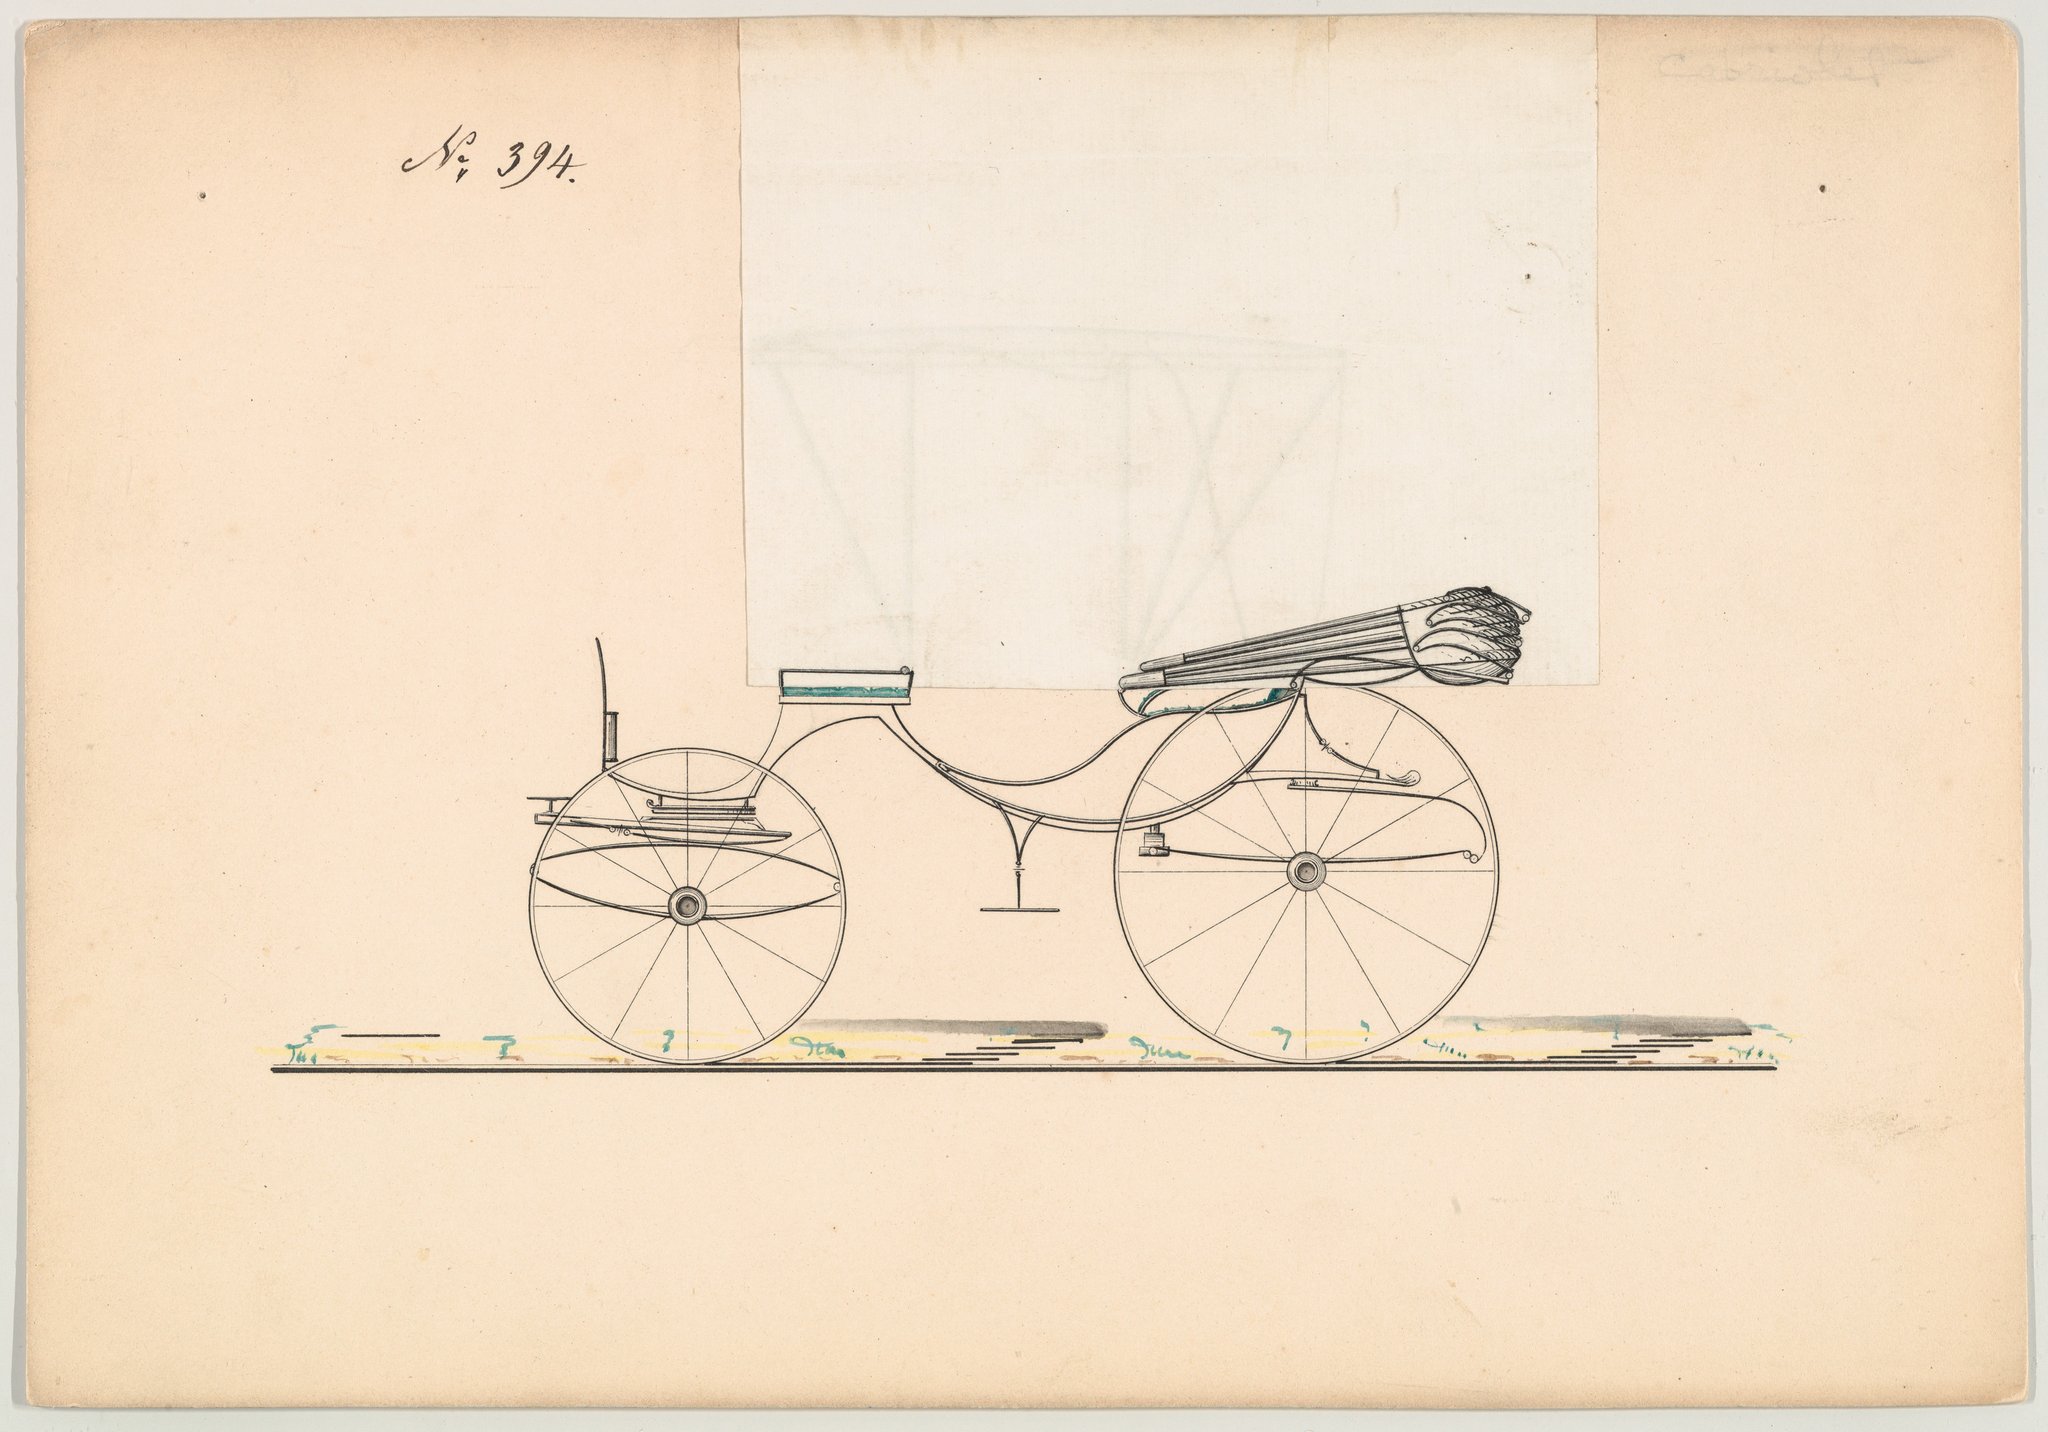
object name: drawing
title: Design for Cabriolet, no. 394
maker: brewster & co.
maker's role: manufacturer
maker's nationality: american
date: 1850-1870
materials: gouache, ink, watercolor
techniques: pen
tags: carriages